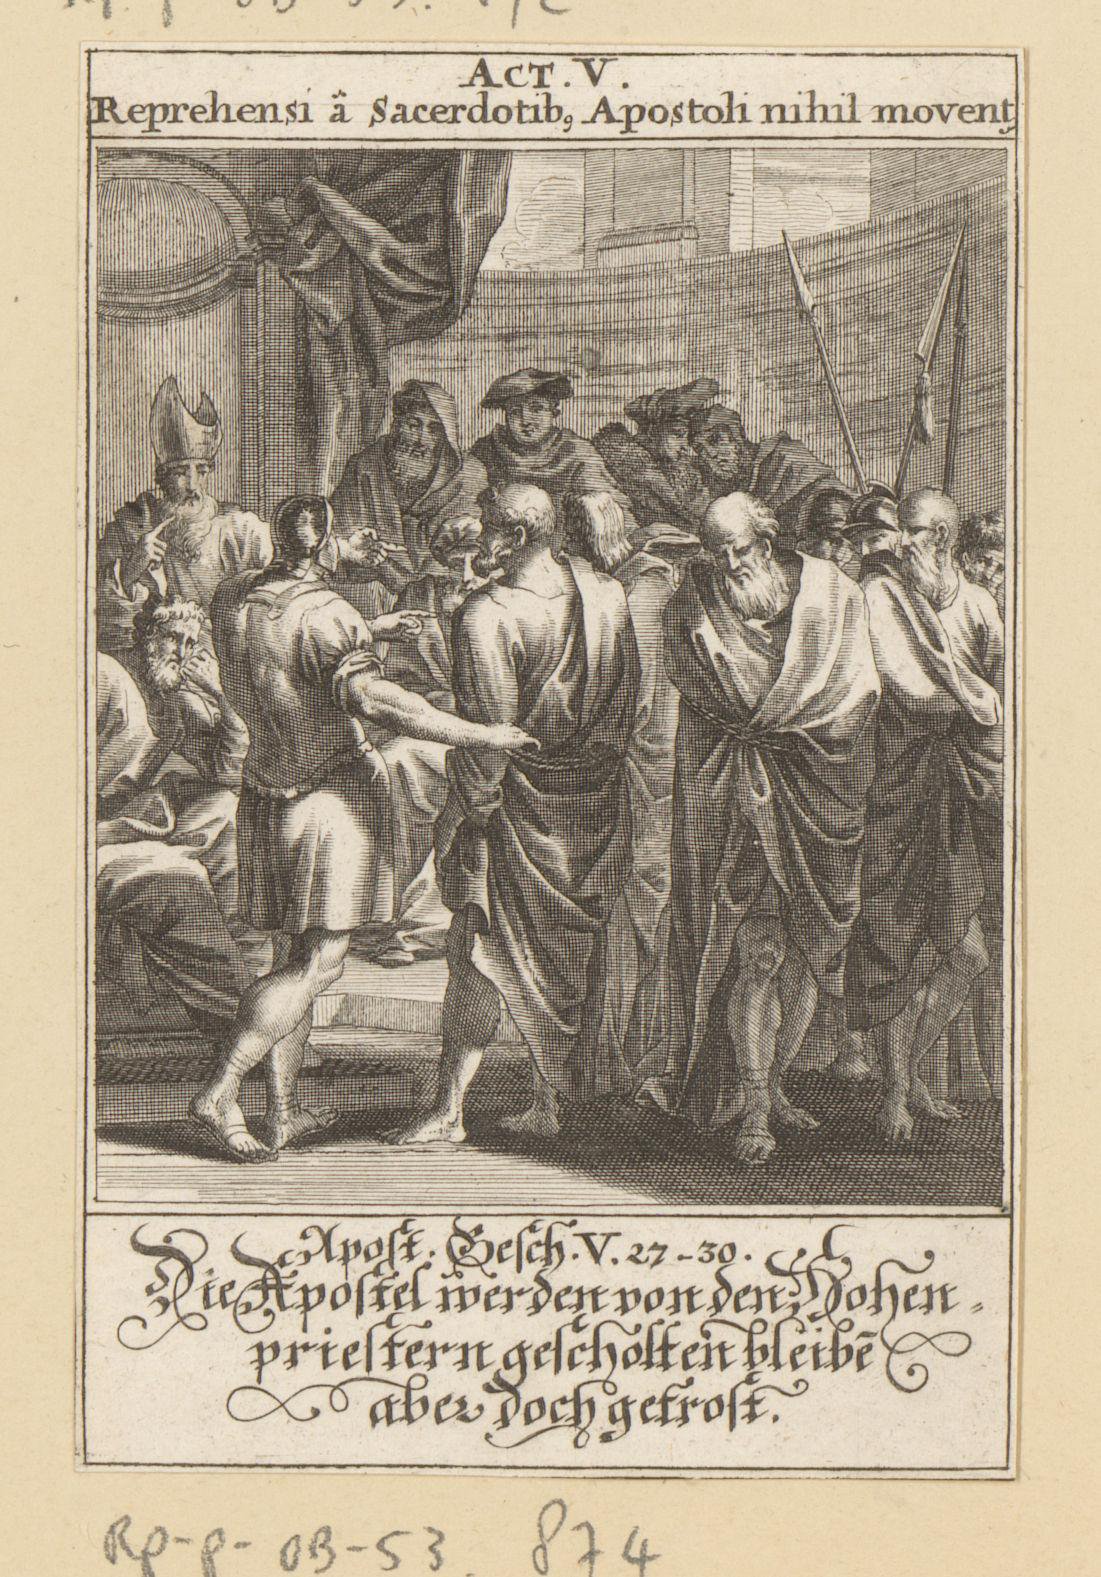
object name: print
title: Apostelen raken niet bewogen door de woorden van de hogepriester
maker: Anonymous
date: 1697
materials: paper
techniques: etching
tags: the high priest and sadducees have peter and the apostles put in prison (acts 5:17-42)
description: Prent ook gebruikt in: Biblia ectypa : Bildnussen auss Heiliger Schrifft. Regensburg: Chr. Wiegel, 1697.